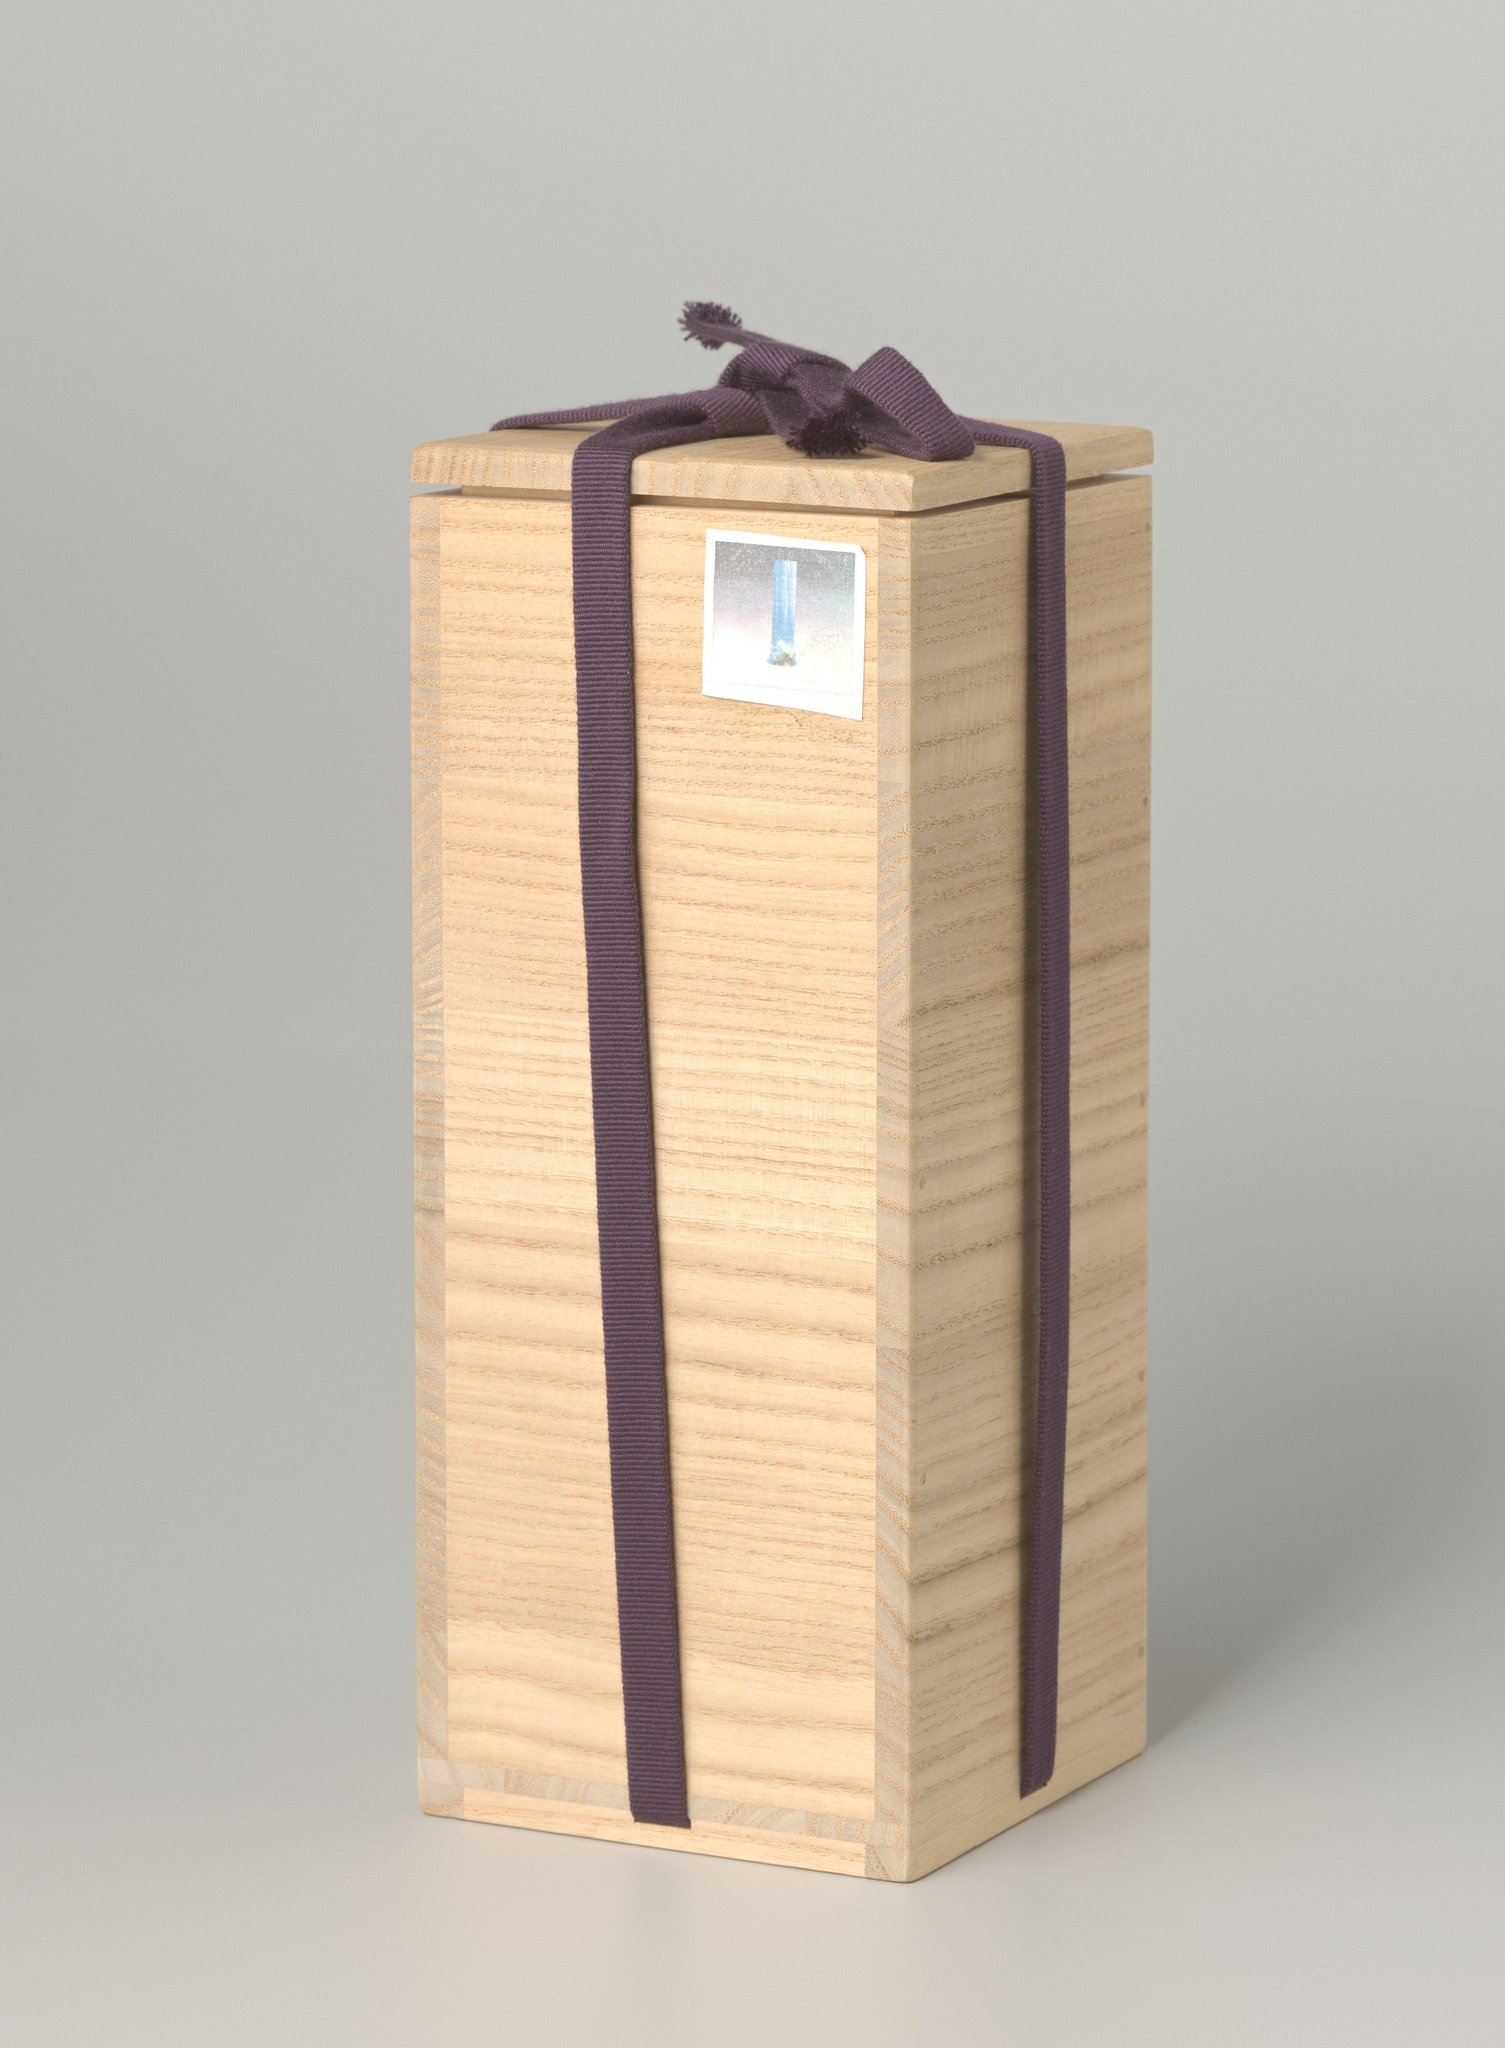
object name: box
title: Doosje behorende bij cilindervormige vaas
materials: wood